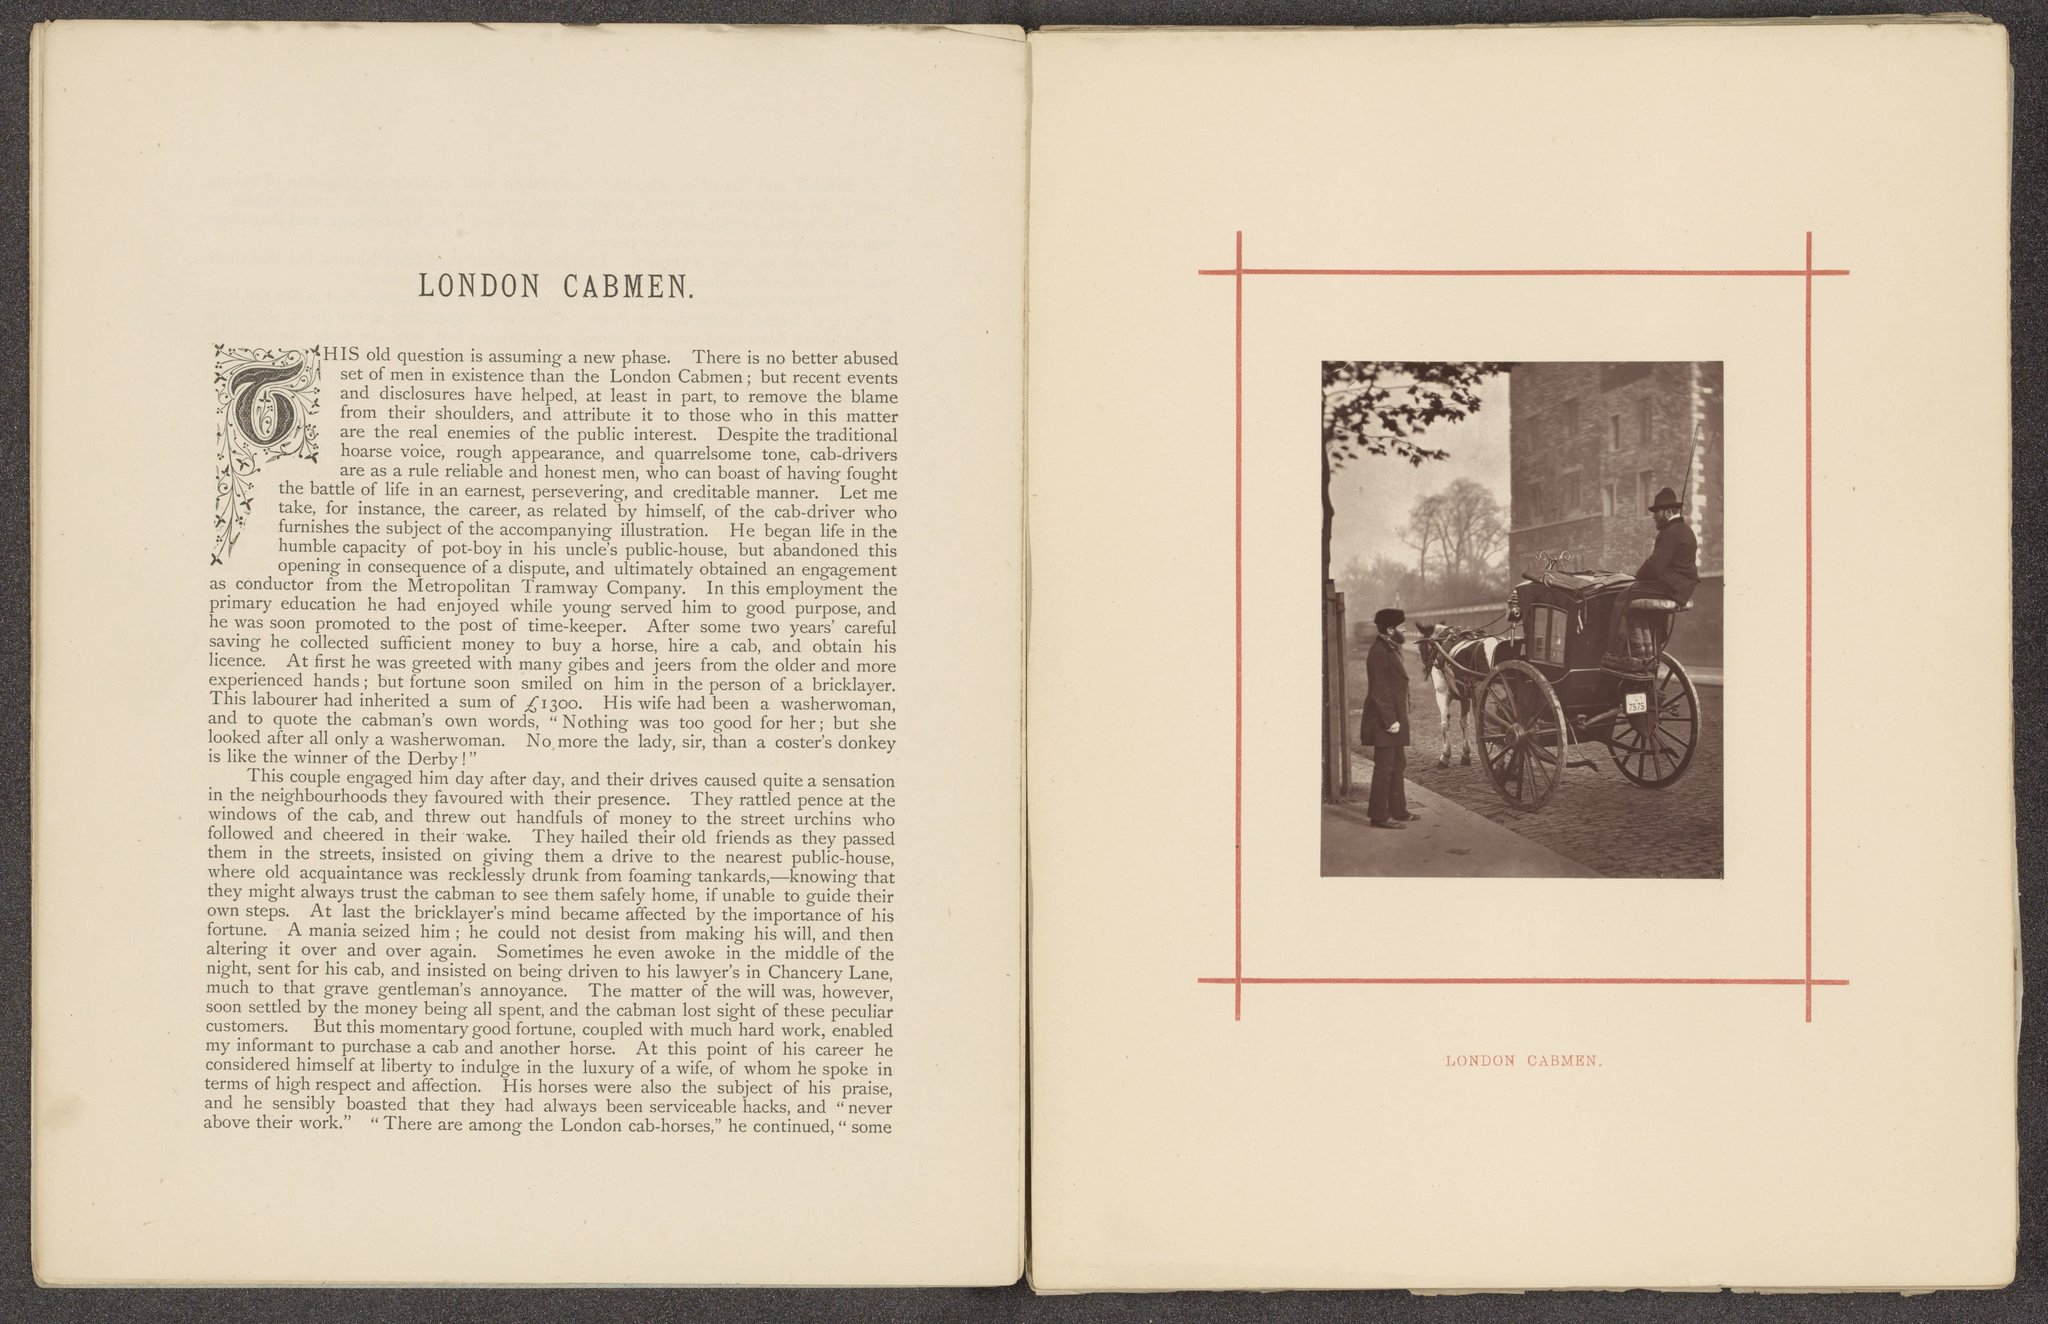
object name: photomechanical print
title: Street Life in London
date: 1877-1878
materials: paper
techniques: woodburytype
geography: london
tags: bus, coach, two-wheeled, animal-drawn vehicle, london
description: The recording of street sellers and types has a long tradition in the visual arts. Printed Cris de Paris and Street Cries of London date back centuries. The theme was also embraced by photography. Thomson portrayed London’s flower and newspaper sellers, gypsies, chimney sweeps, and the fishmonger of St. Giles. The photographs were accompanied by Smith’s stories.